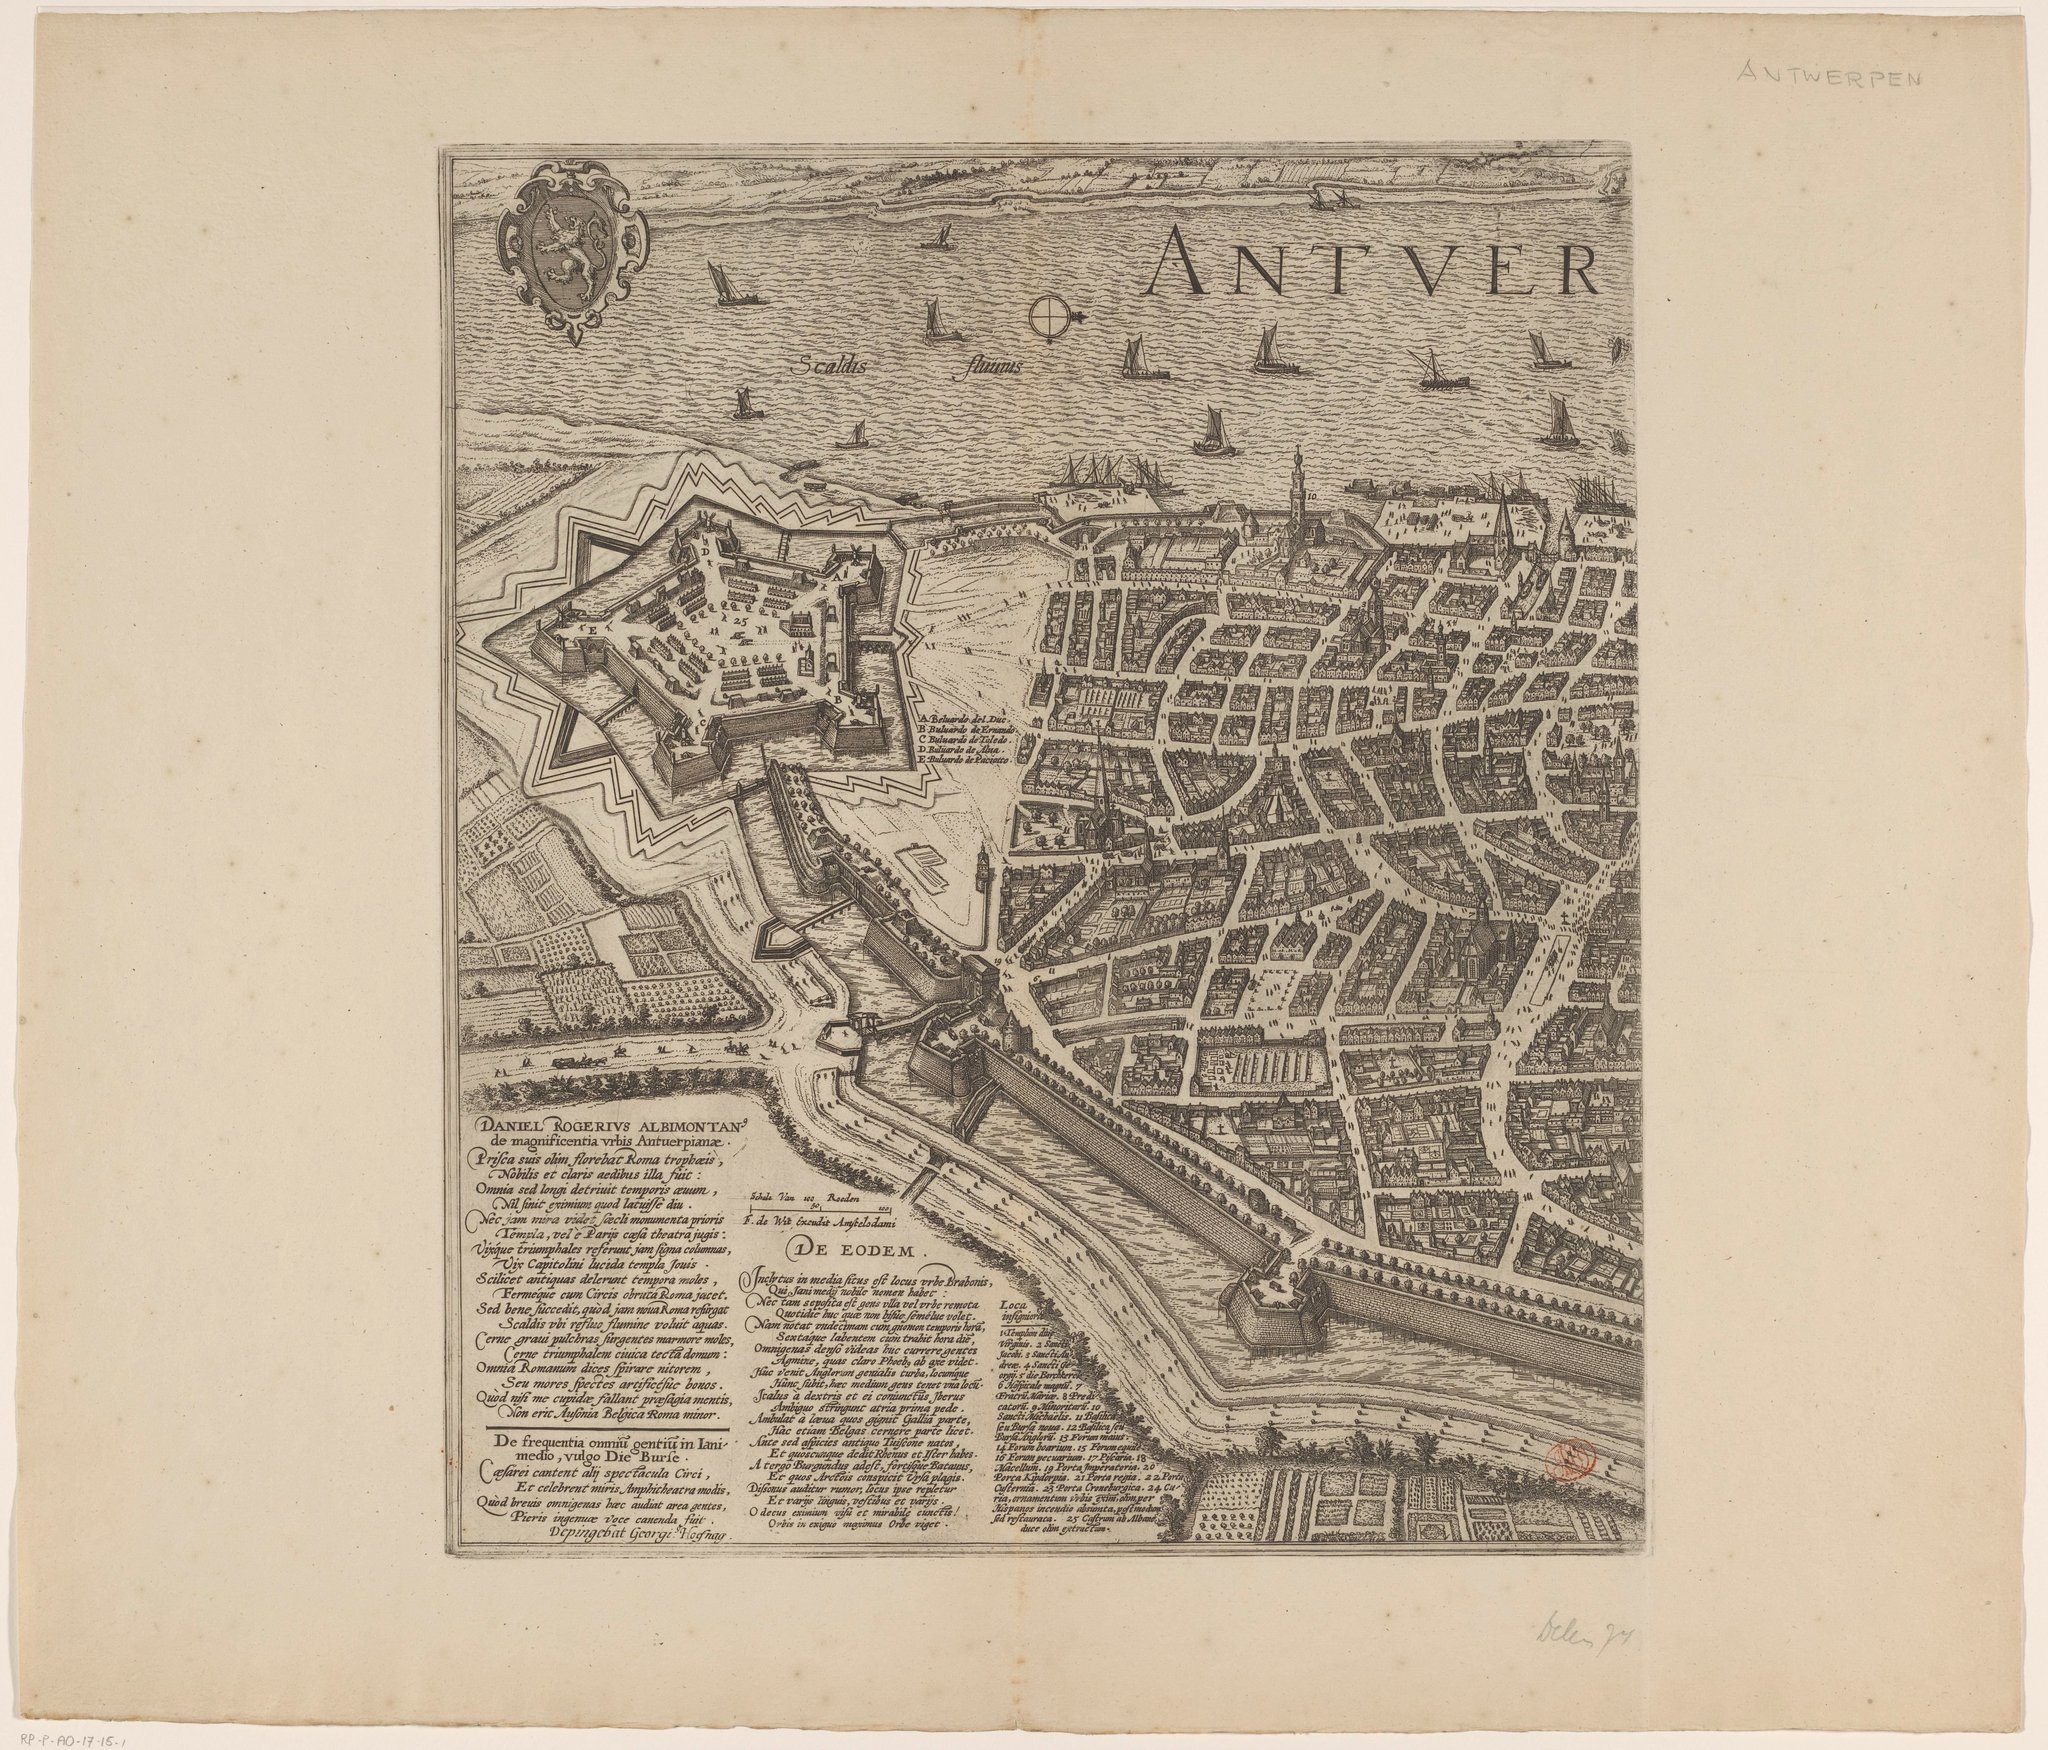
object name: area plan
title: Plattegrond van Antwerpen (linkerdeel)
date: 1596-1597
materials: paper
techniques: engraving, etching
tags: fortified city, maps of cities, coat of arms (as symbol of the state, etc.) (+ province; provincial), prospect of city, town panorama, silhouette of city, antwerp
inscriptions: collector's mark: Lugt 195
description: Huidige staat van prent ook gebruikt in: Theatrum ichnographicum omnium urbium et praecipuorum oppidorum Belgicarum XVII Provinciarum (…). Amsterdam: Frederik de Wit, ca. 1700-1710. En in: Aa, Pieter van der. La galerie agreable du monde (…). 66 delen. Leiden: Pieter van der Aa, 1728, dl. 16.